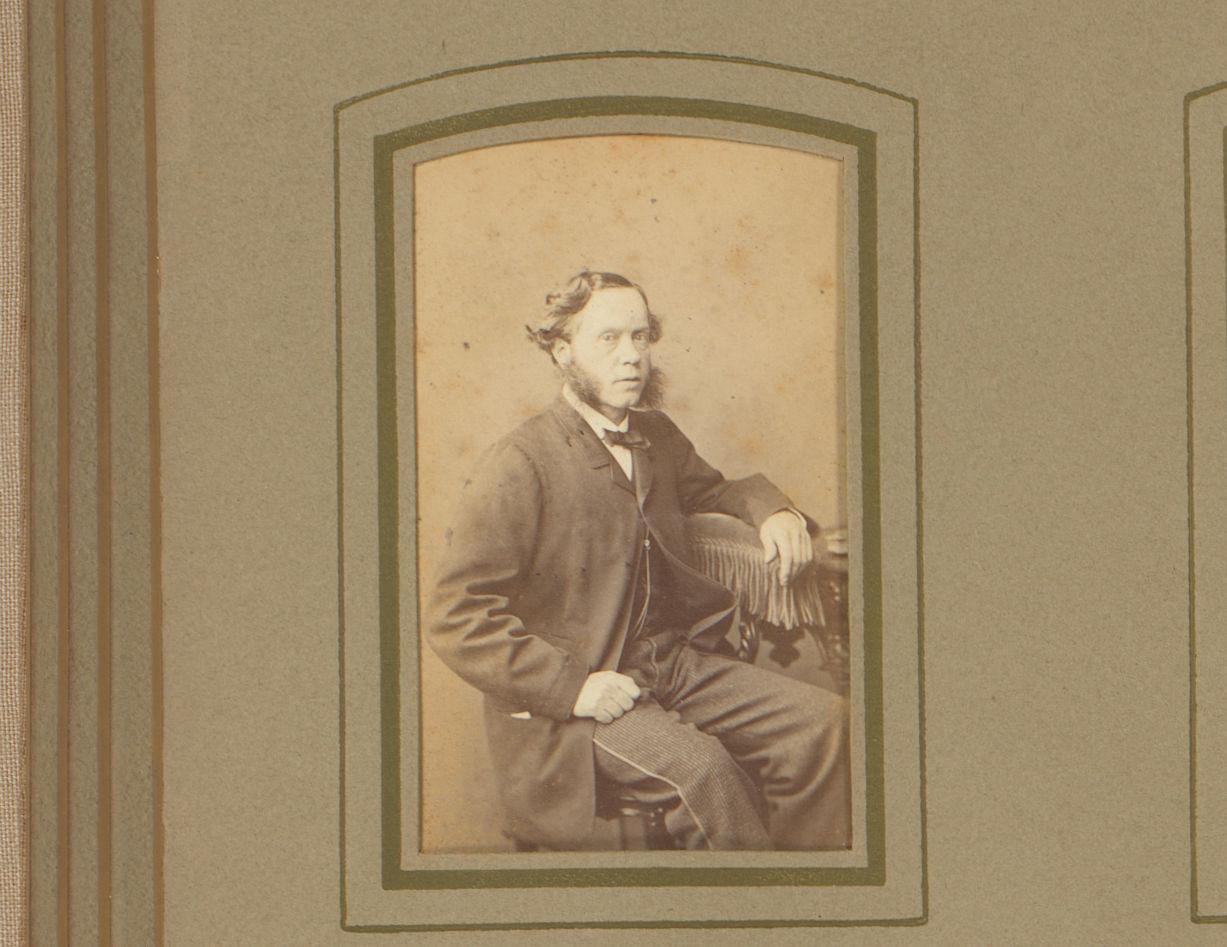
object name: album leaf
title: Portret van een man met bakkebaarden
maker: matthijs adolph conen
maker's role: painter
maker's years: 1833-1894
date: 1862-1880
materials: cardboard, photographic support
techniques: albumen print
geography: amsterdam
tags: sideburns, sitting figure, historical persons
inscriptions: inscription: ‘ADOLPHE CONEN/ PEINTRE-PHOTOGRAPHE/ AMSTERDAM.’